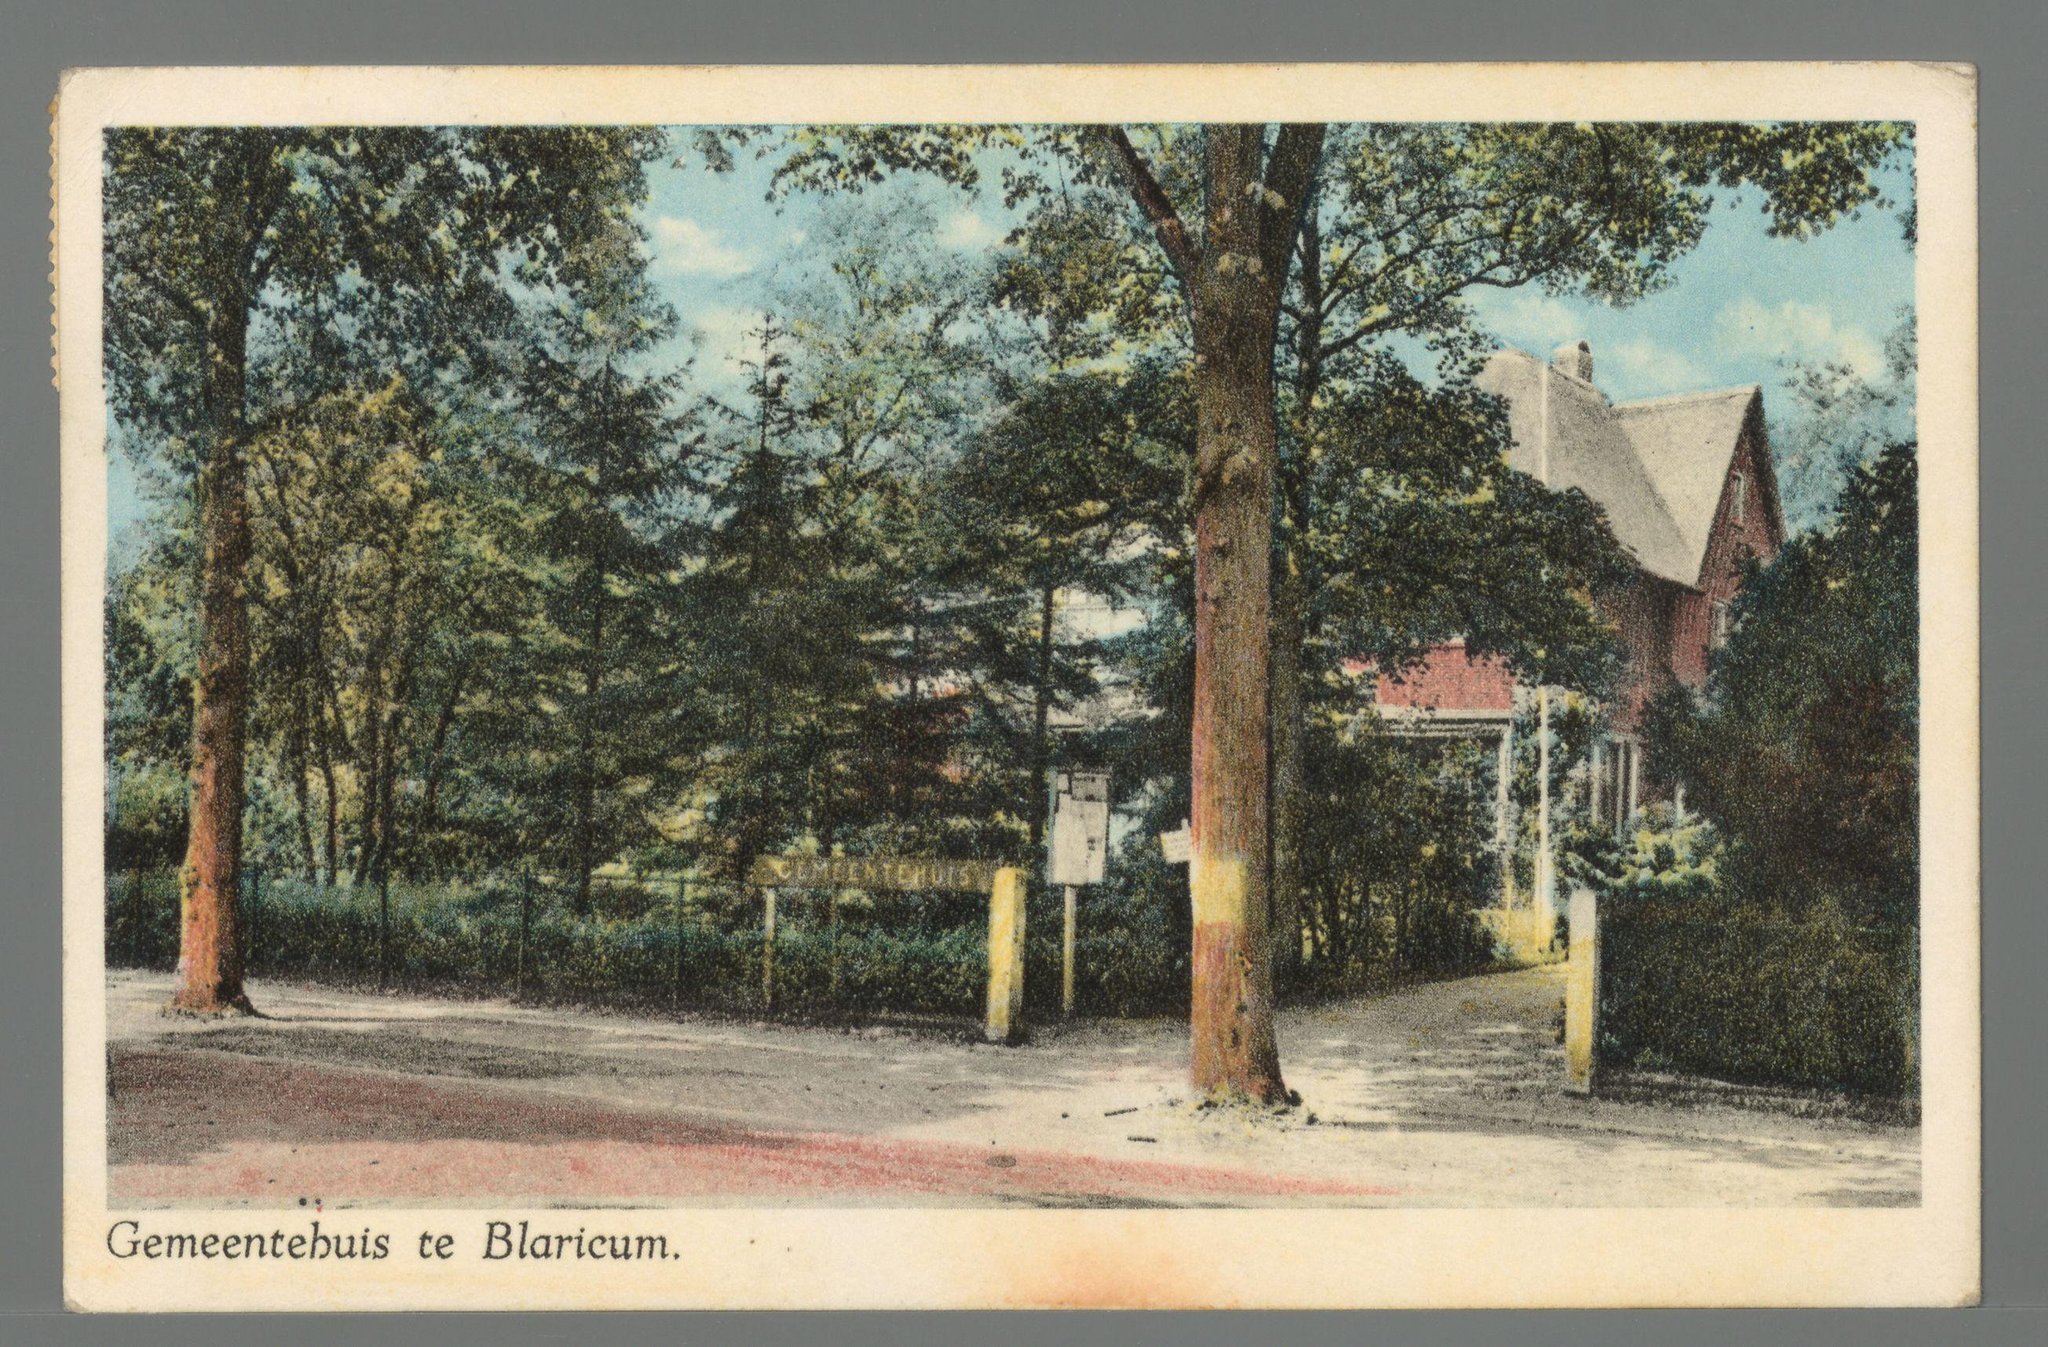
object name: ansichtkaart, prentbriefkaart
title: Gemeentehuis te Blaricum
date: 1945-1954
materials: cardboard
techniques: photograph, lithograph, writing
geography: blaricum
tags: city-view, and landscape with man-made constructions, townhall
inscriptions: postage stamp